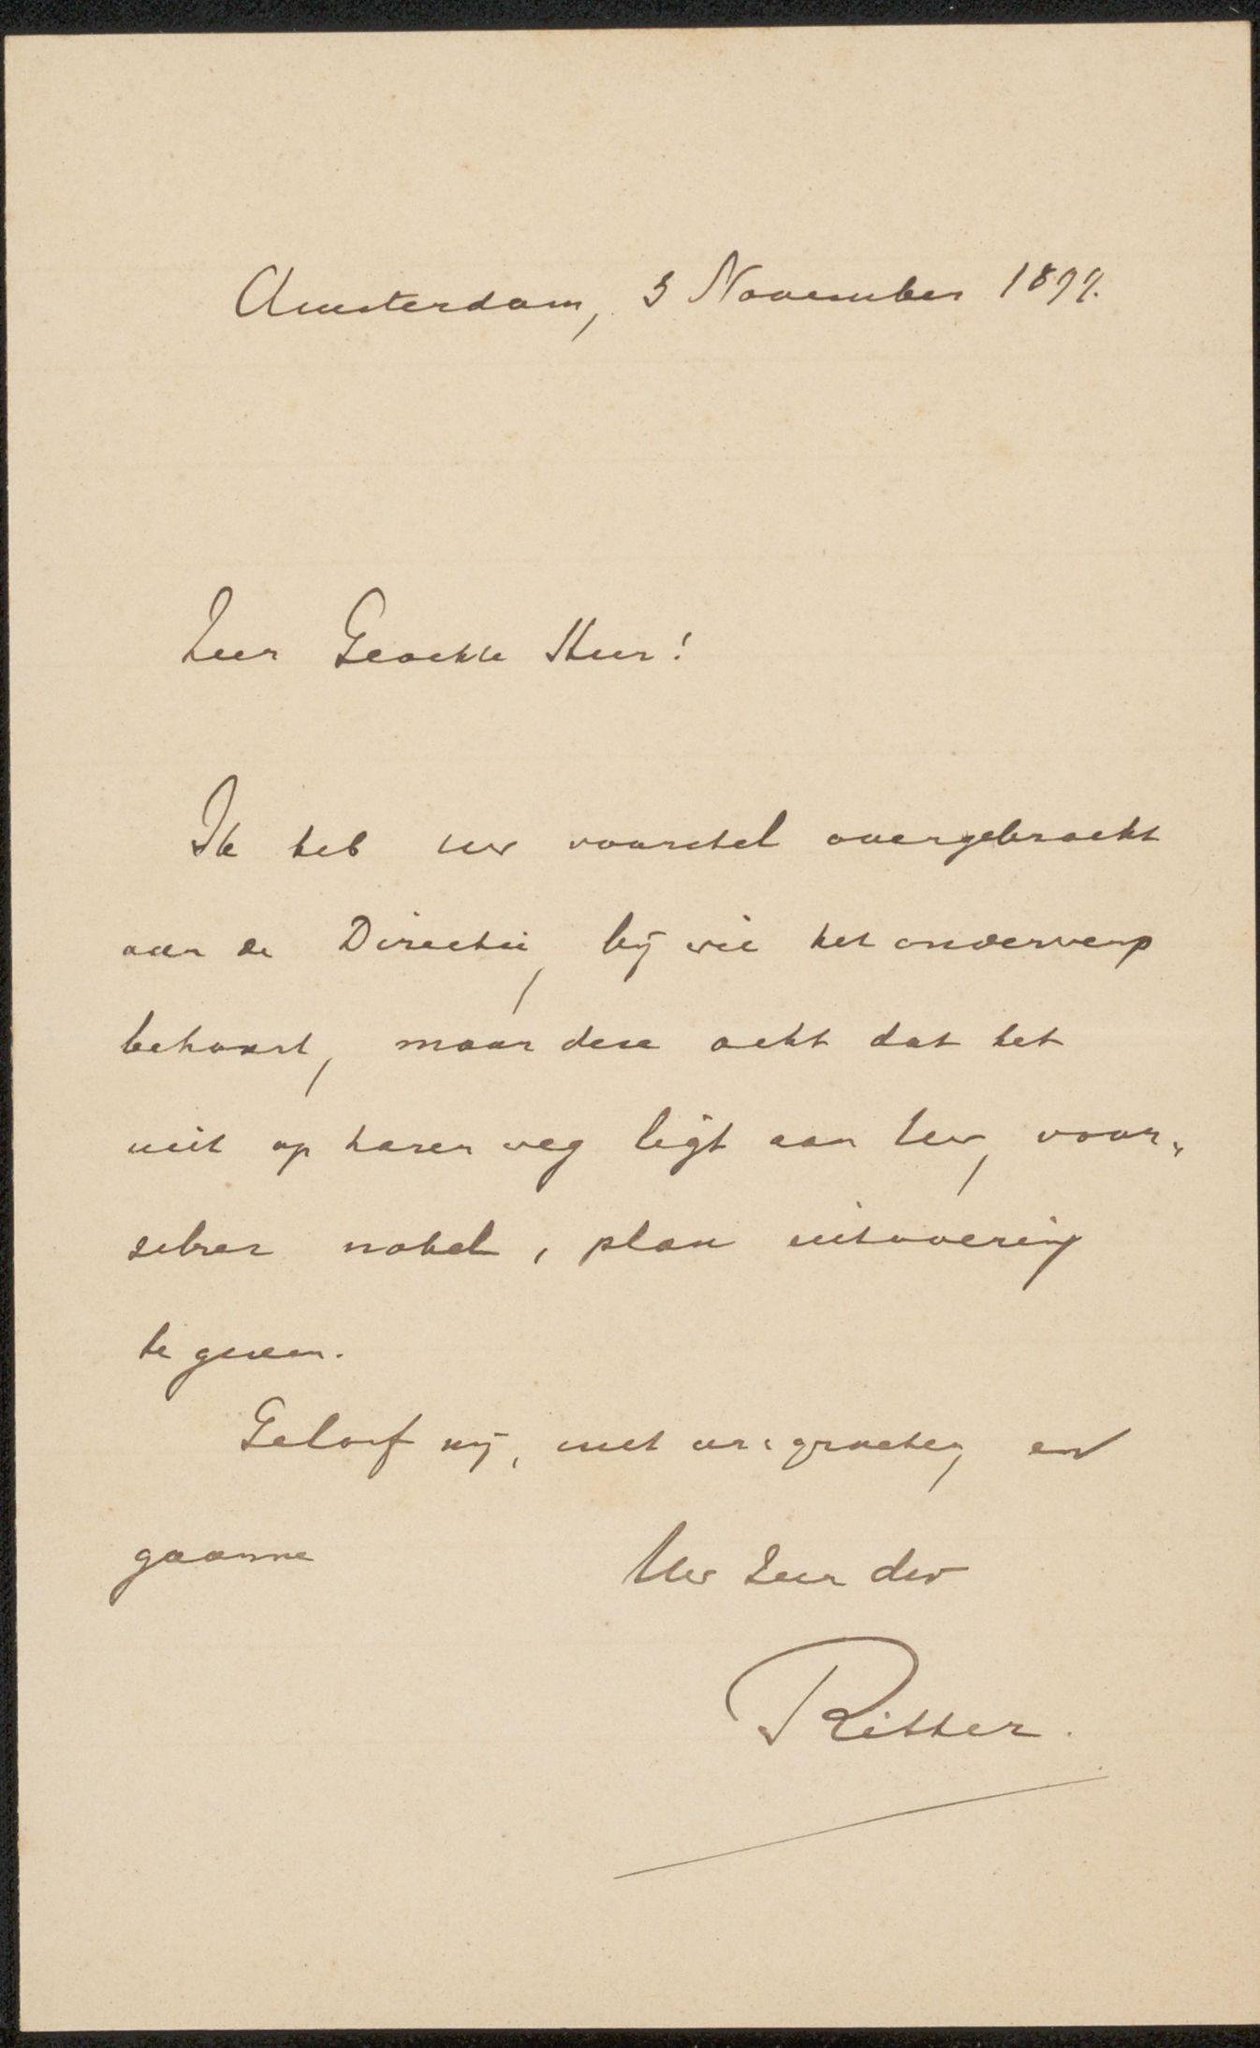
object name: letter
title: Brief aan Philip Zilcken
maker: pierre henri ritter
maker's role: dominee, hoofdredacteur, hoogleraar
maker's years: 1851-1912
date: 1899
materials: ink, paper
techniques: pen, writing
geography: amsterdam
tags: the hague, painter, draughtsman, philip zilcken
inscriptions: collector's mark: ‘RPK’